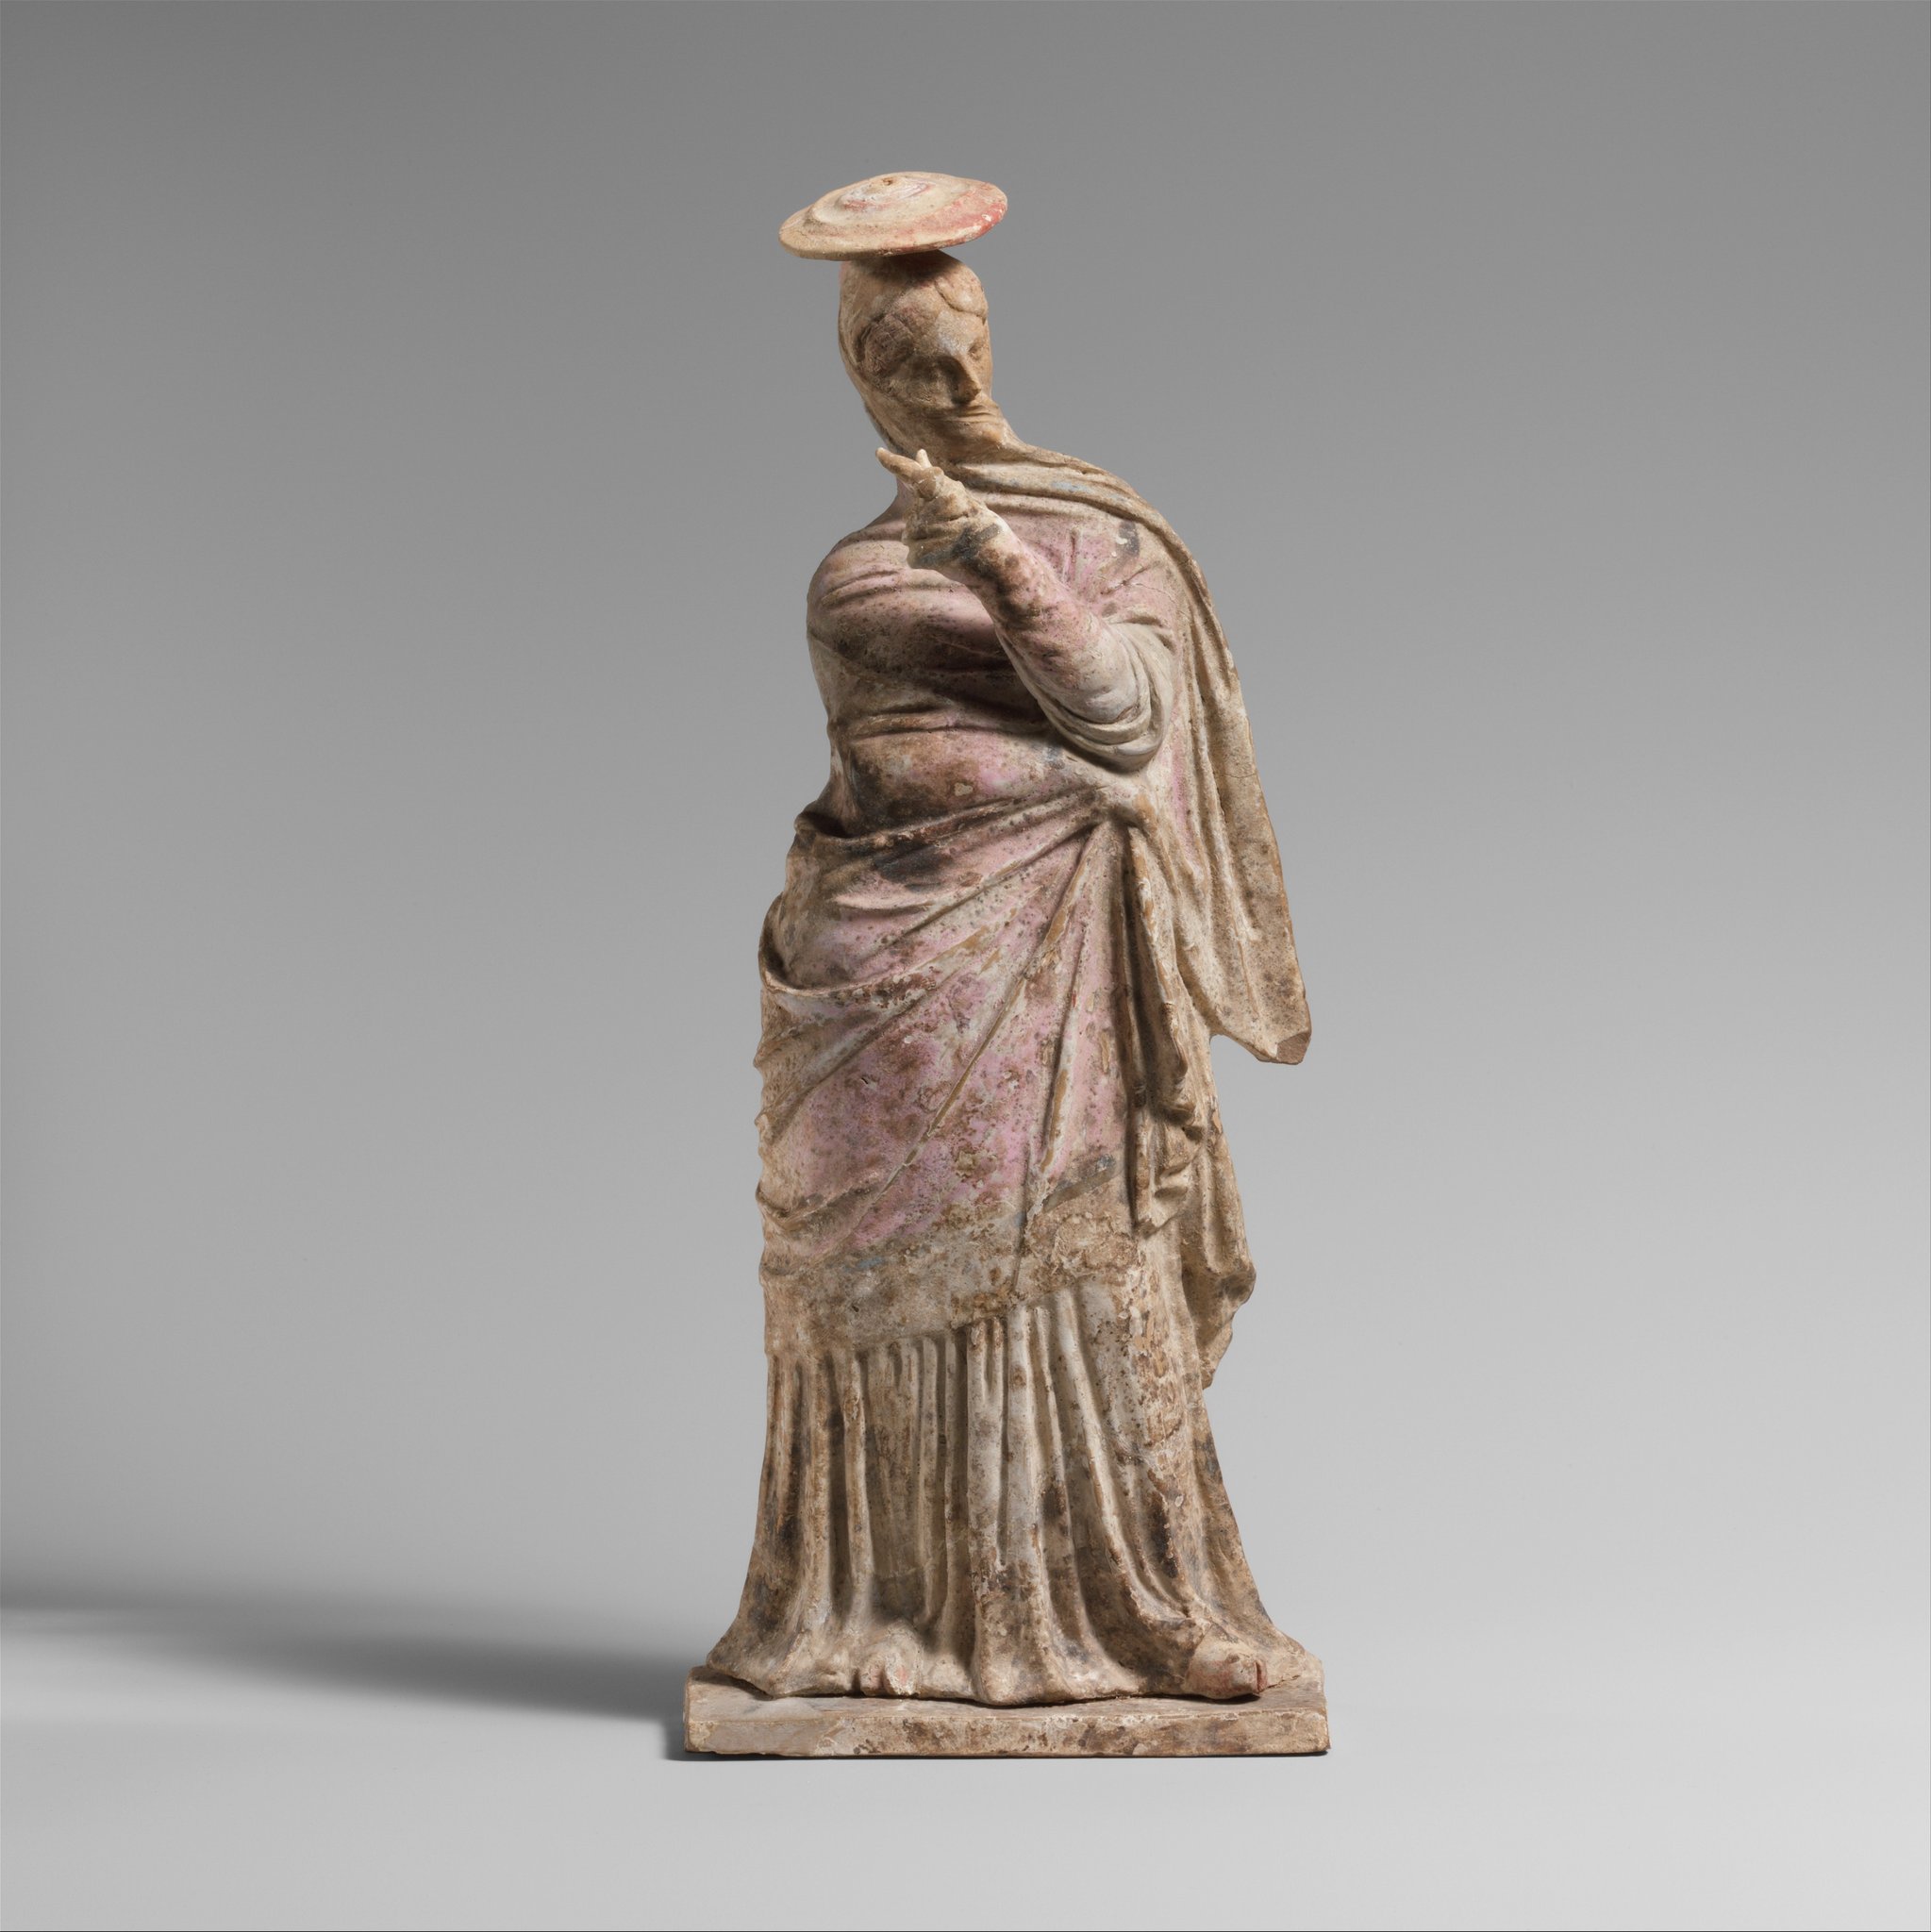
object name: statuette of a woman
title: Terracotta statuette of a woman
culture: greek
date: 200-101 BCE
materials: terracotta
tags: women